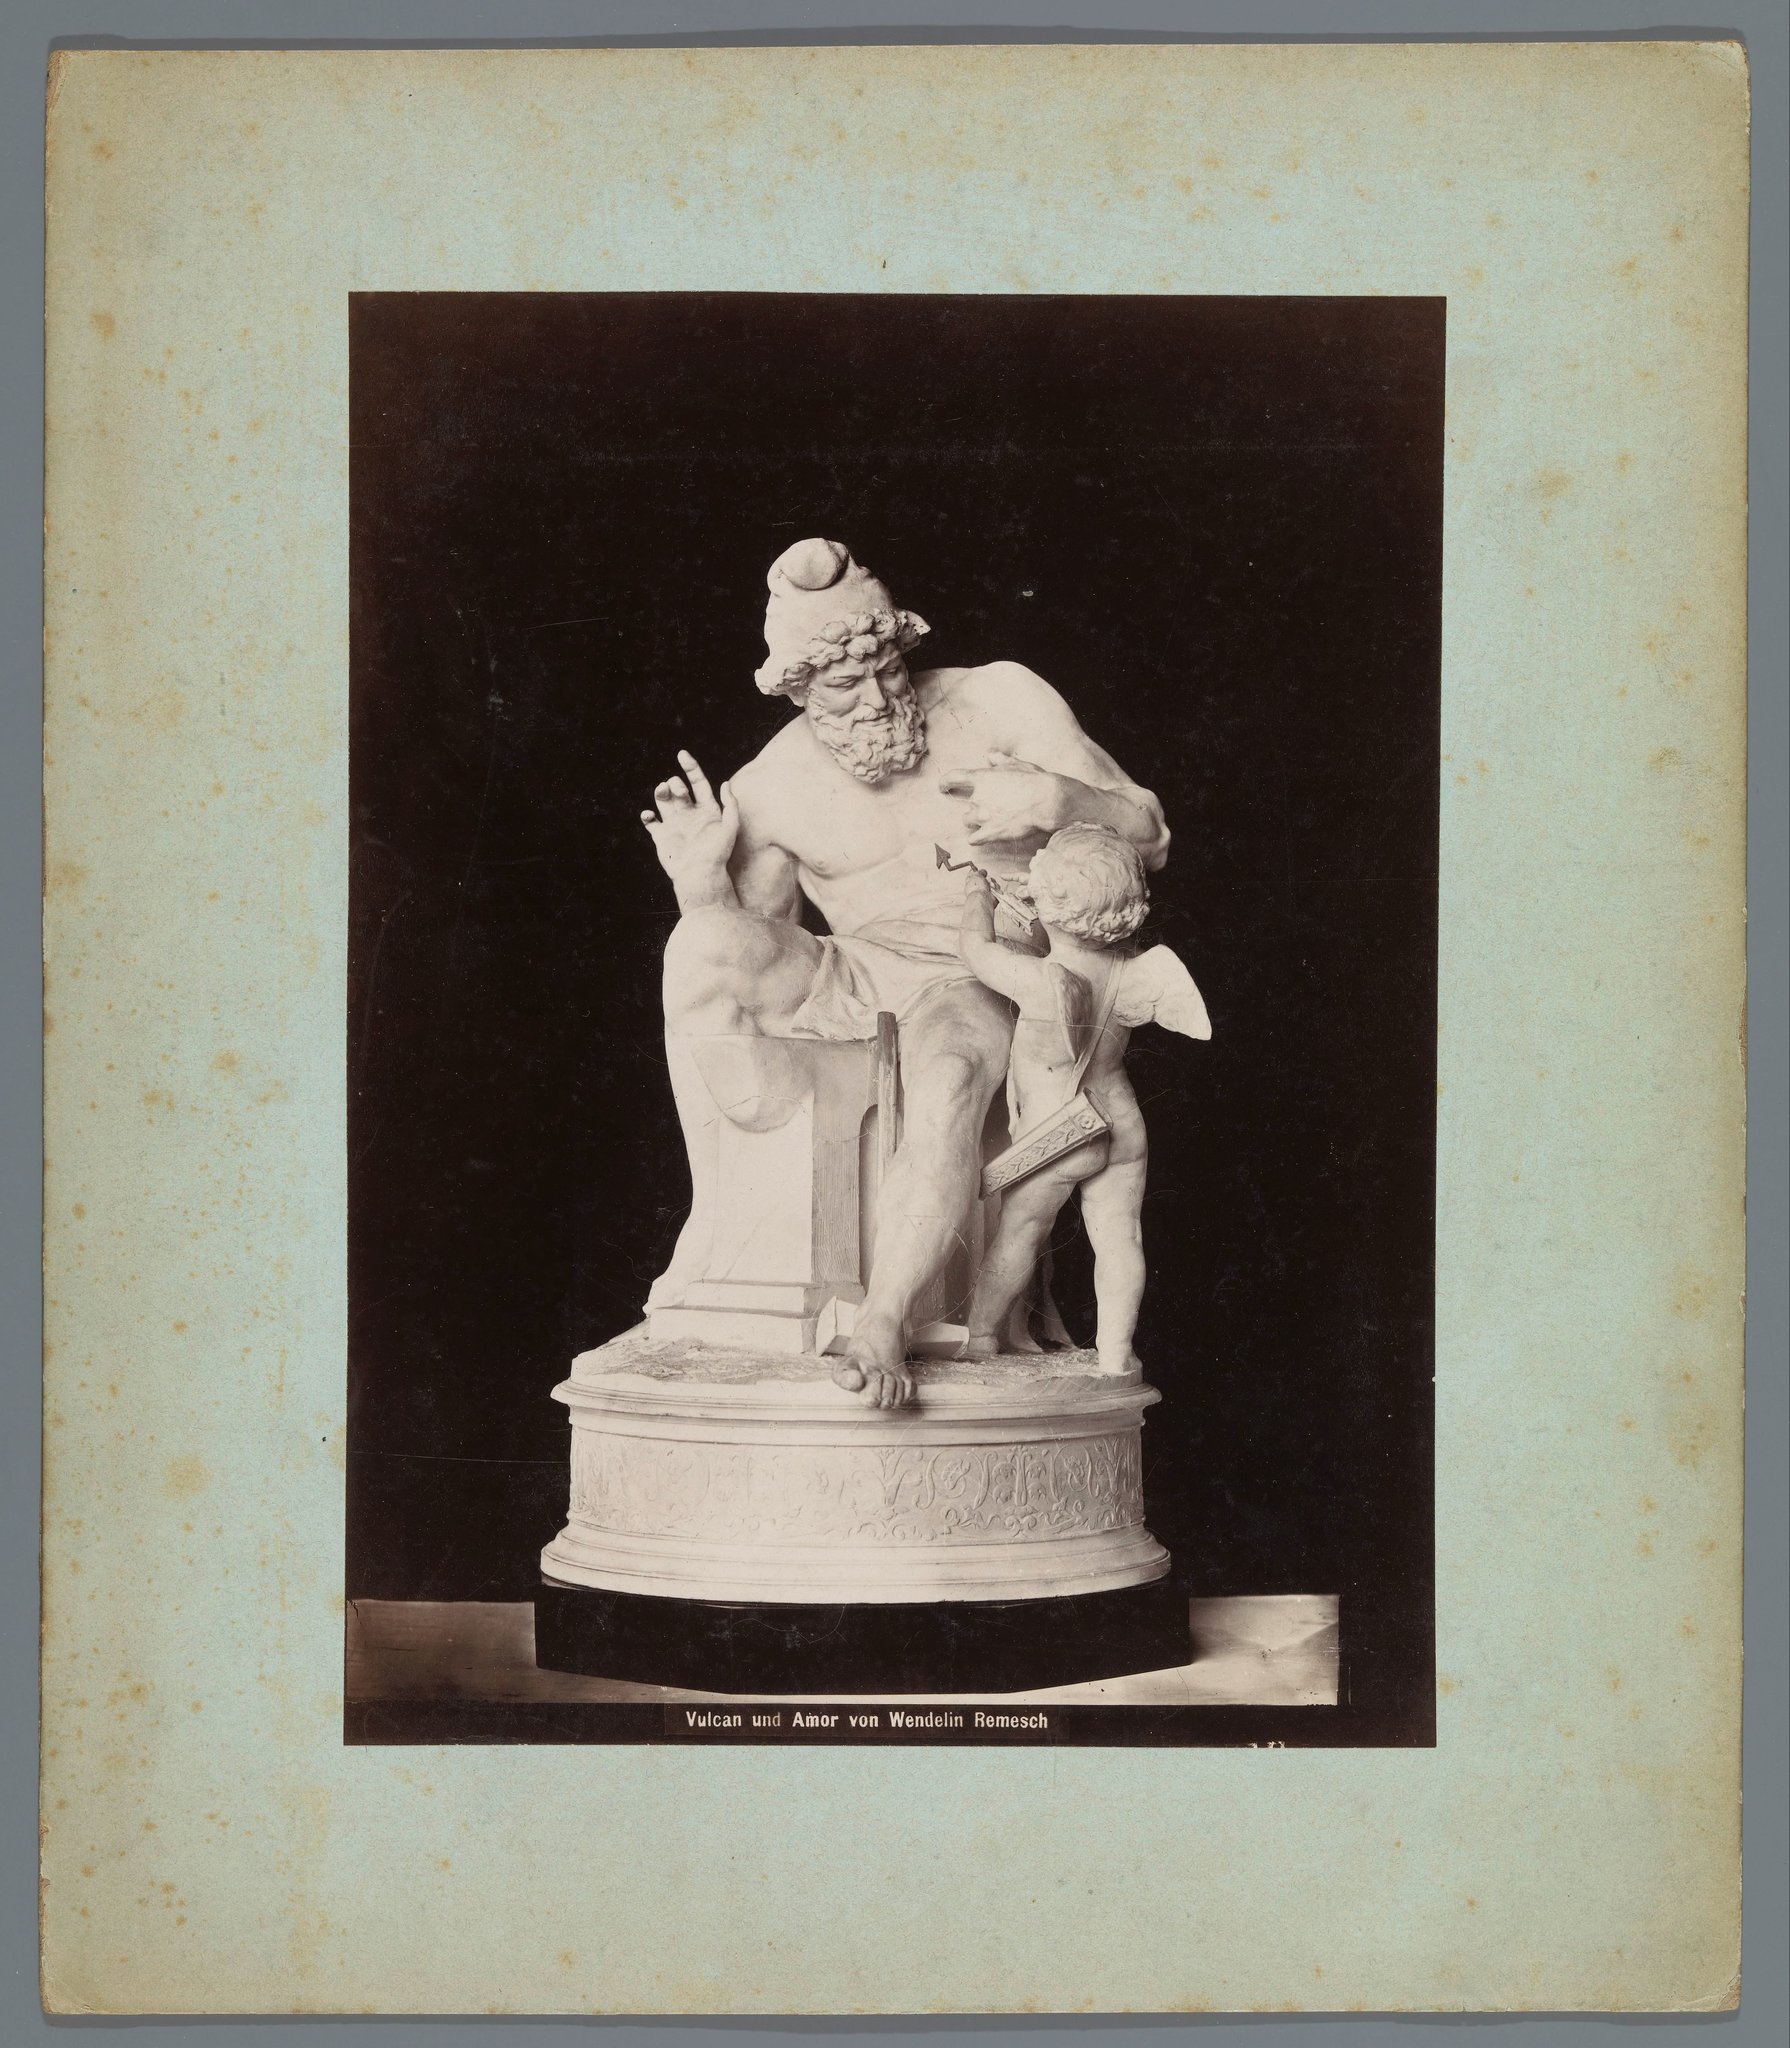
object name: photograph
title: Vulcan und Amor von Wendelin Remesch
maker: j. loroy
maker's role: fotograaf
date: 1875-1900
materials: cardboard, photographic support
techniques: albumen print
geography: europe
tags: (story of) vulcan (hephaestus), (story of) cupid, amor (eros), sculpture, europe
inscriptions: name: ‘J. Löroy Wien’, collector's mark: Lugt 3937